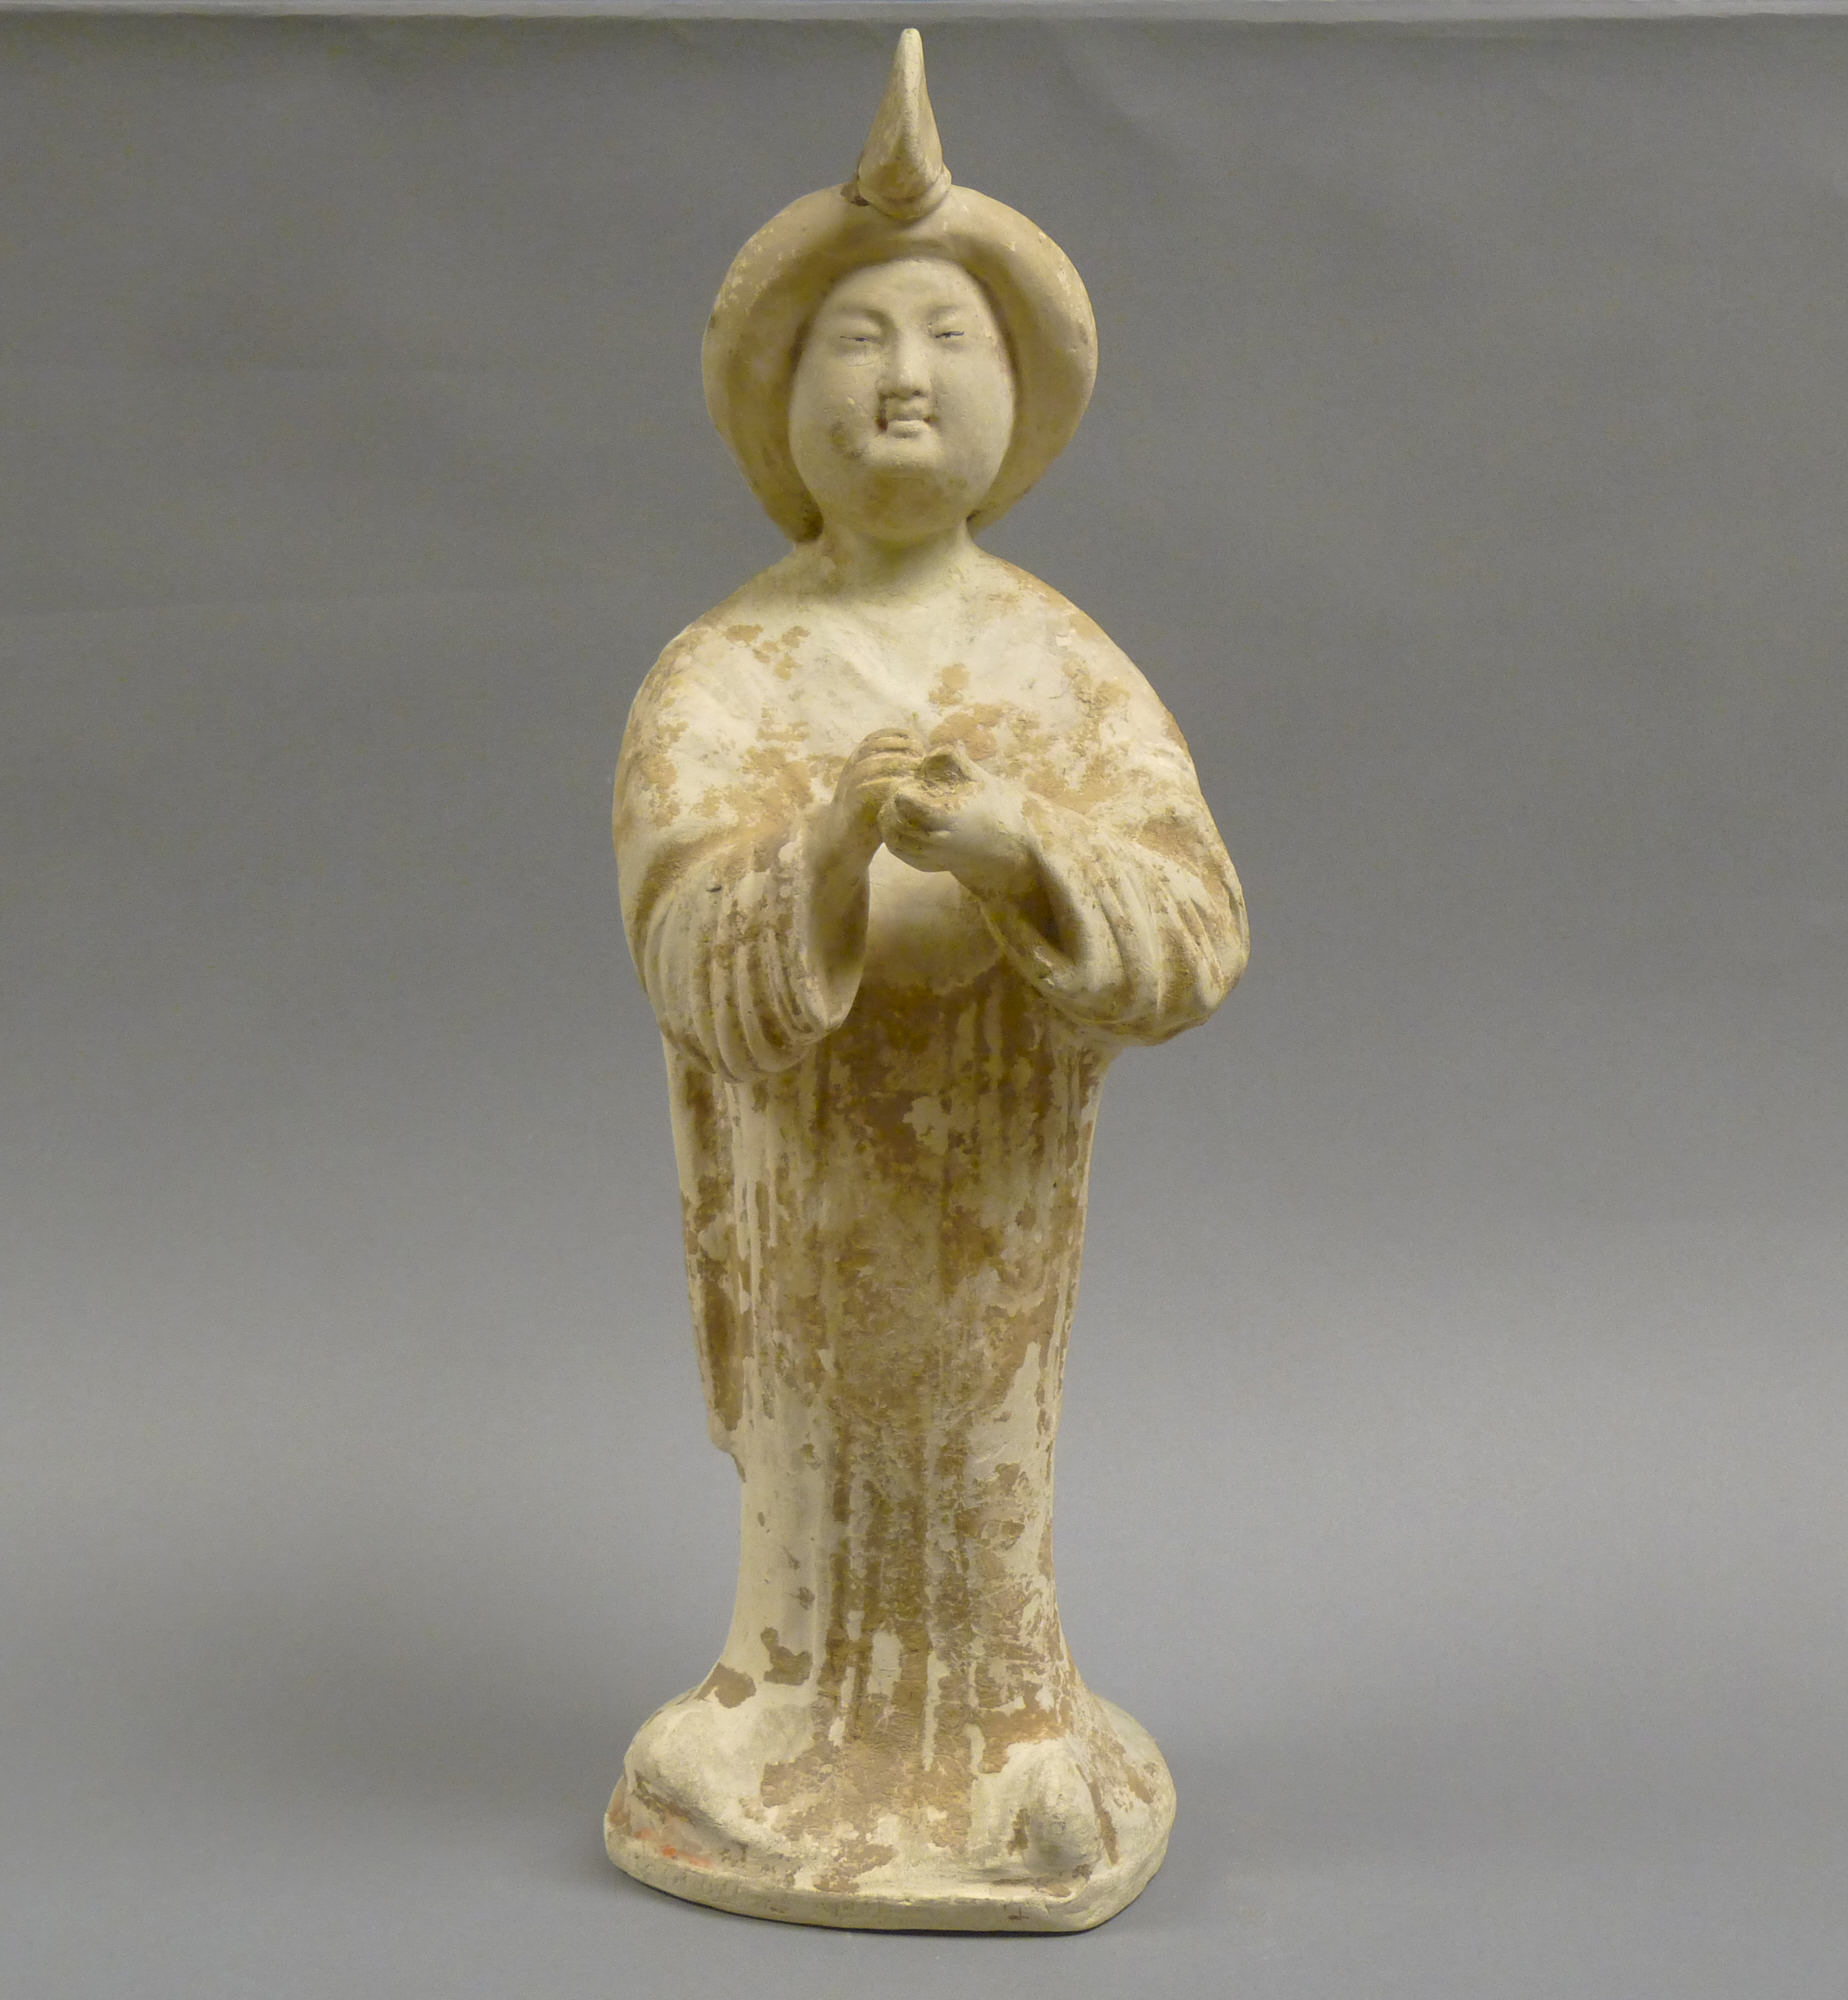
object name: figure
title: Court lady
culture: chinese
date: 701-800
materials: earthenware, pigment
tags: women